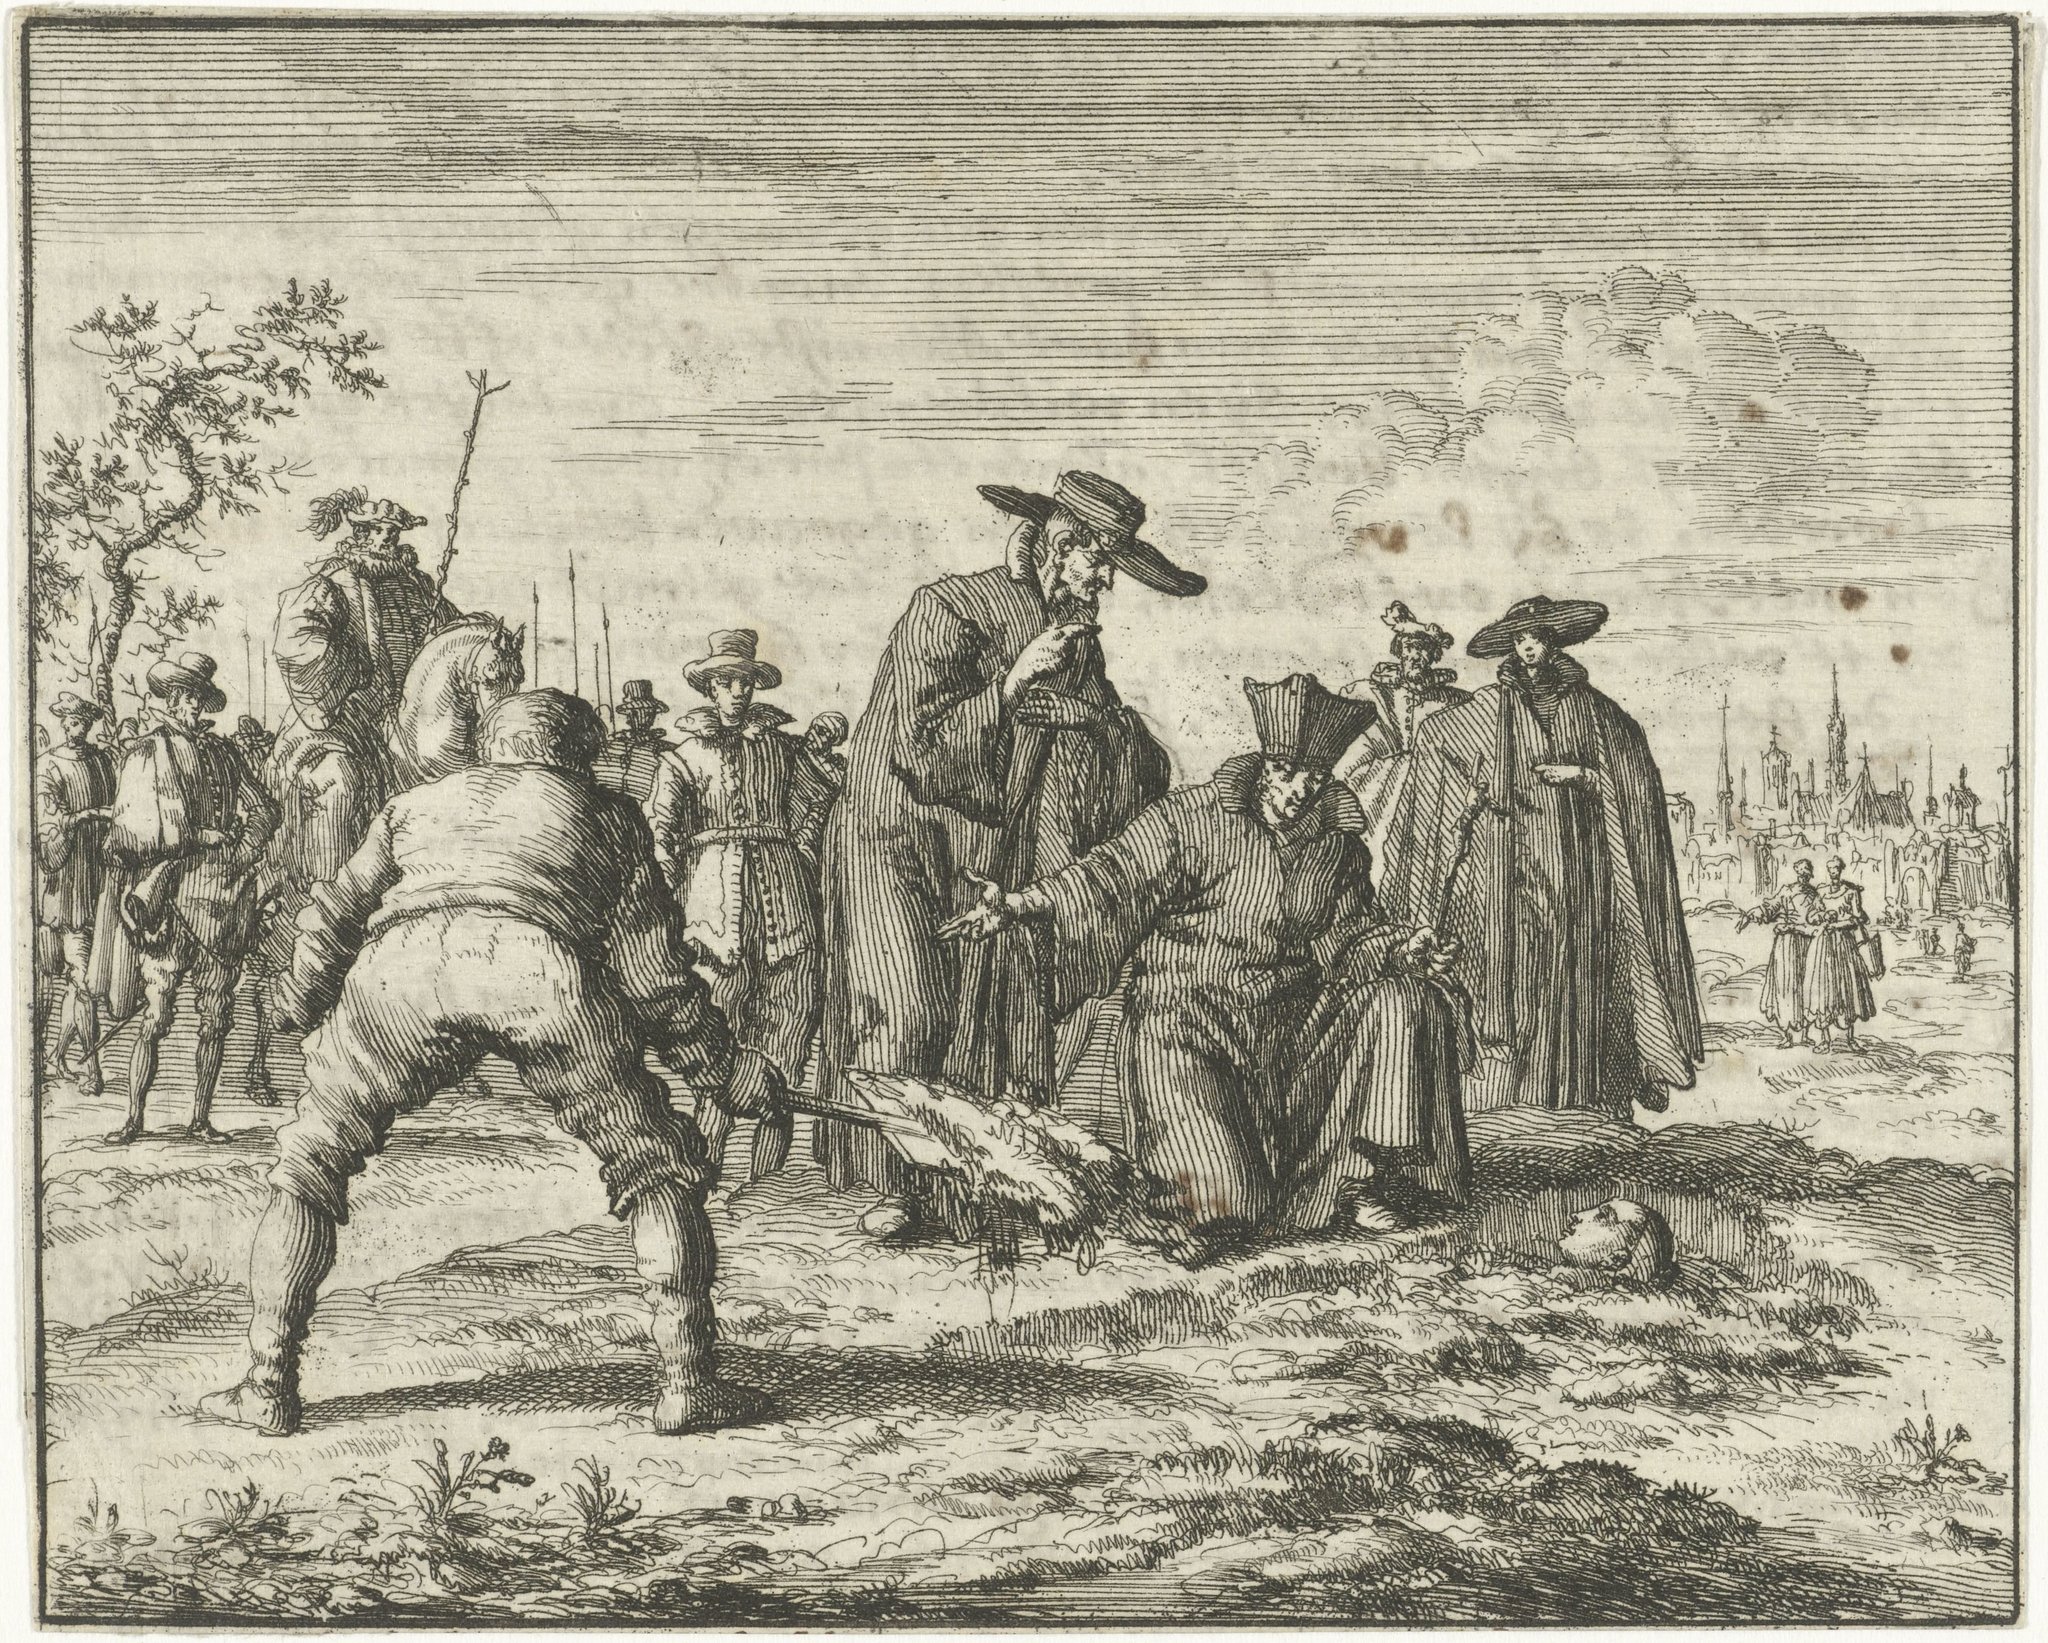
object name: book illustration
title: Anneken van den Hove te Brussel levend begraven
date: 1685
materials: paper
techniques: etching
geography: amsterdam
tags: buried alive (violent death), persecution of heretics, brussels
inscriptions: collector's mark: Lugt 2228, inscription: